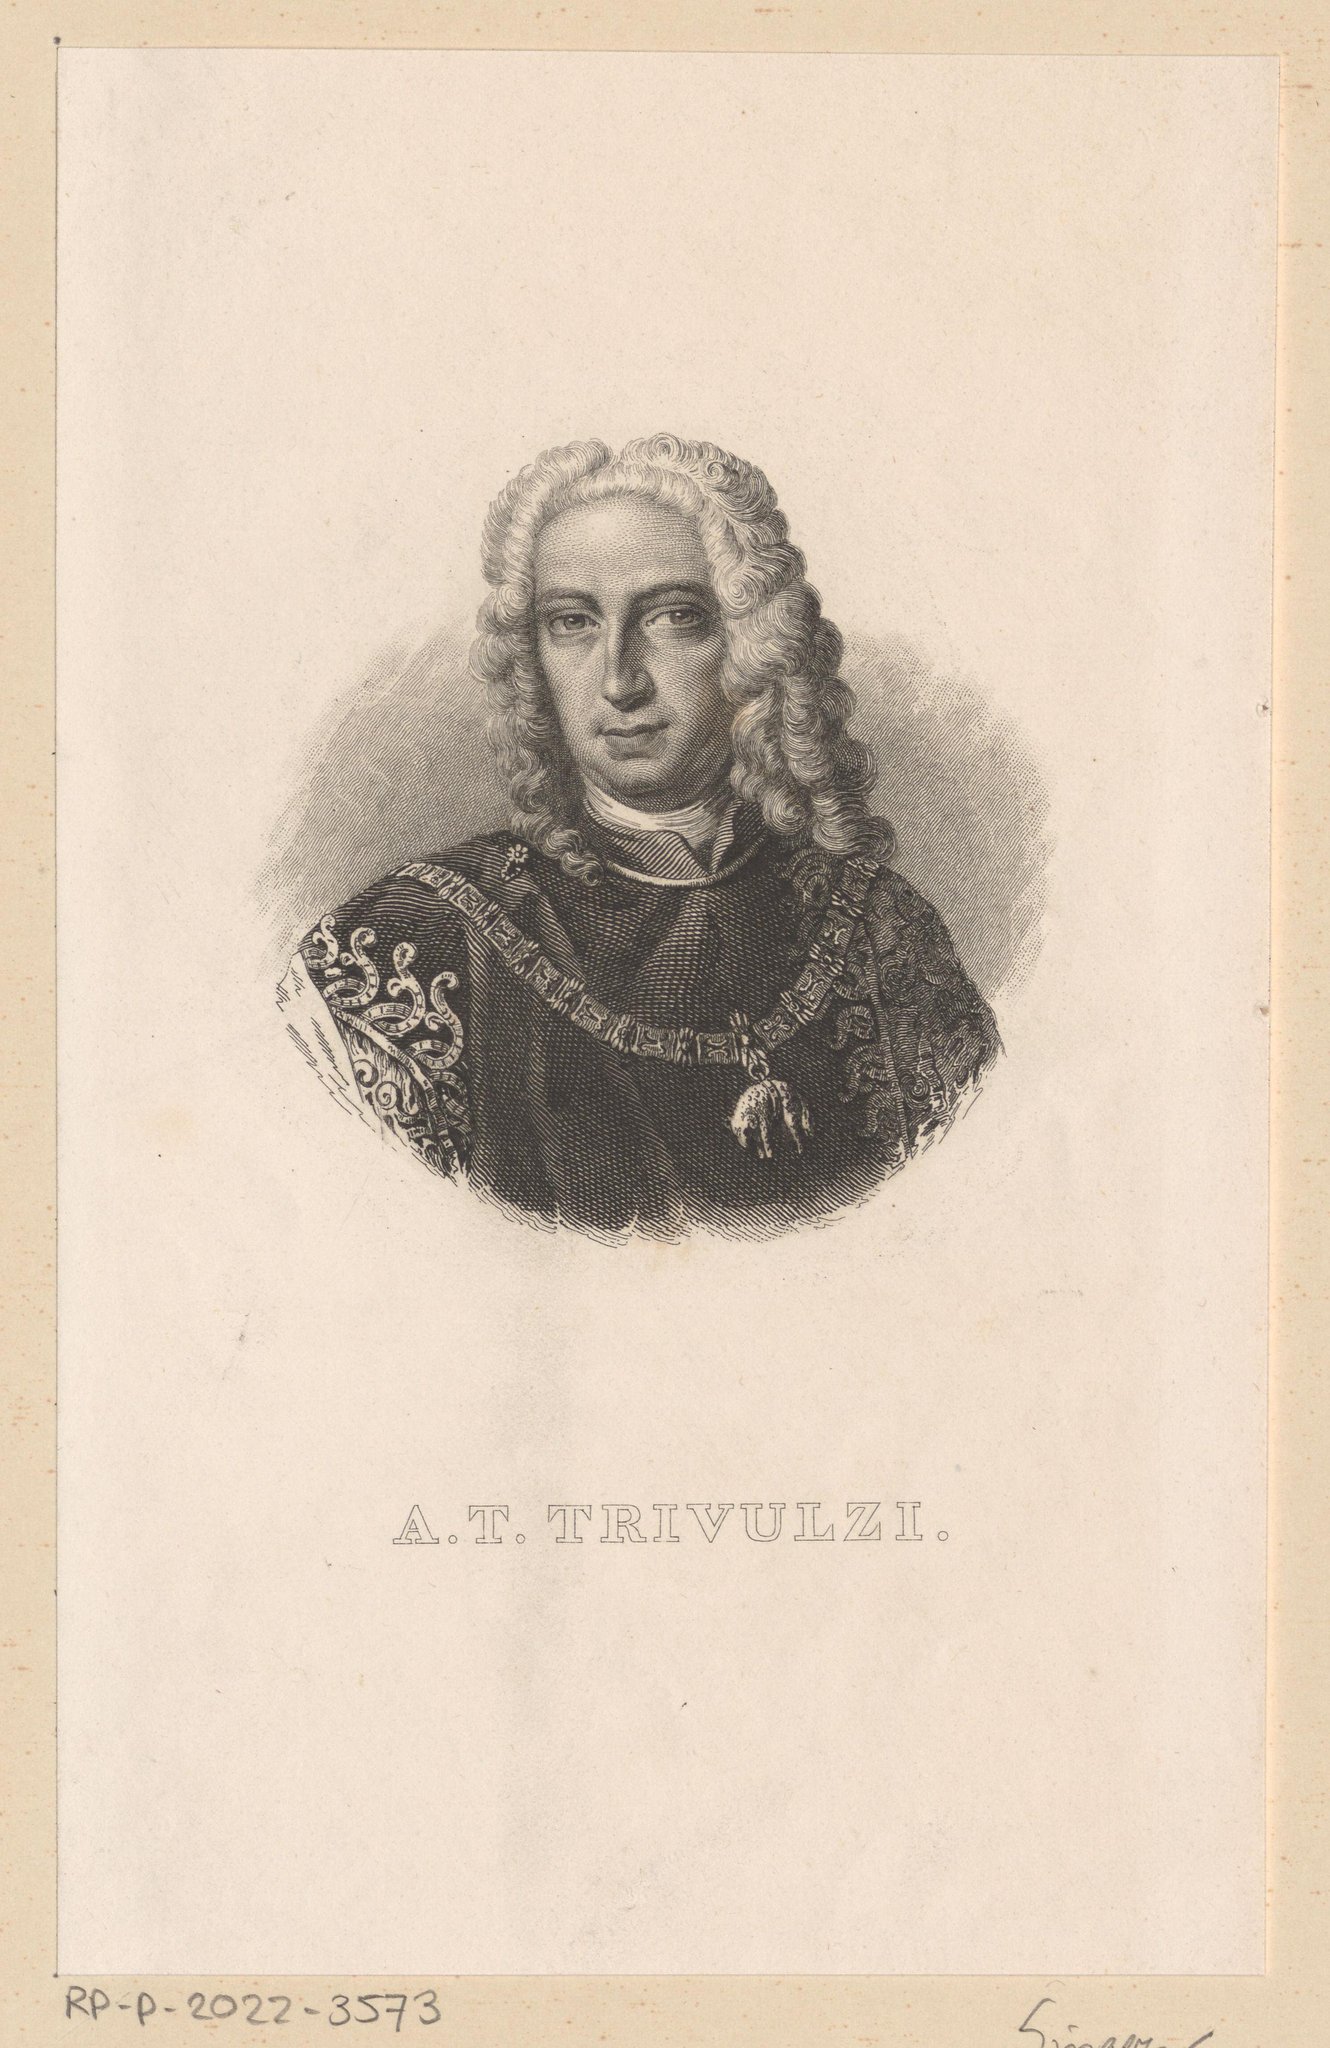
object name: print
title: Portret van Antonio Teodoro Trivulzio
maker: Anonymous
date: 1836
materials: paper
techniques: engraving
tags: historical persons, knighthood order of the golden fleece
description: Prent waarschijnlijk uit: Portraits et histoire des hommes utiles, hommes et femmes (...). Parijs: Société Montyon et Franklin, 1836.